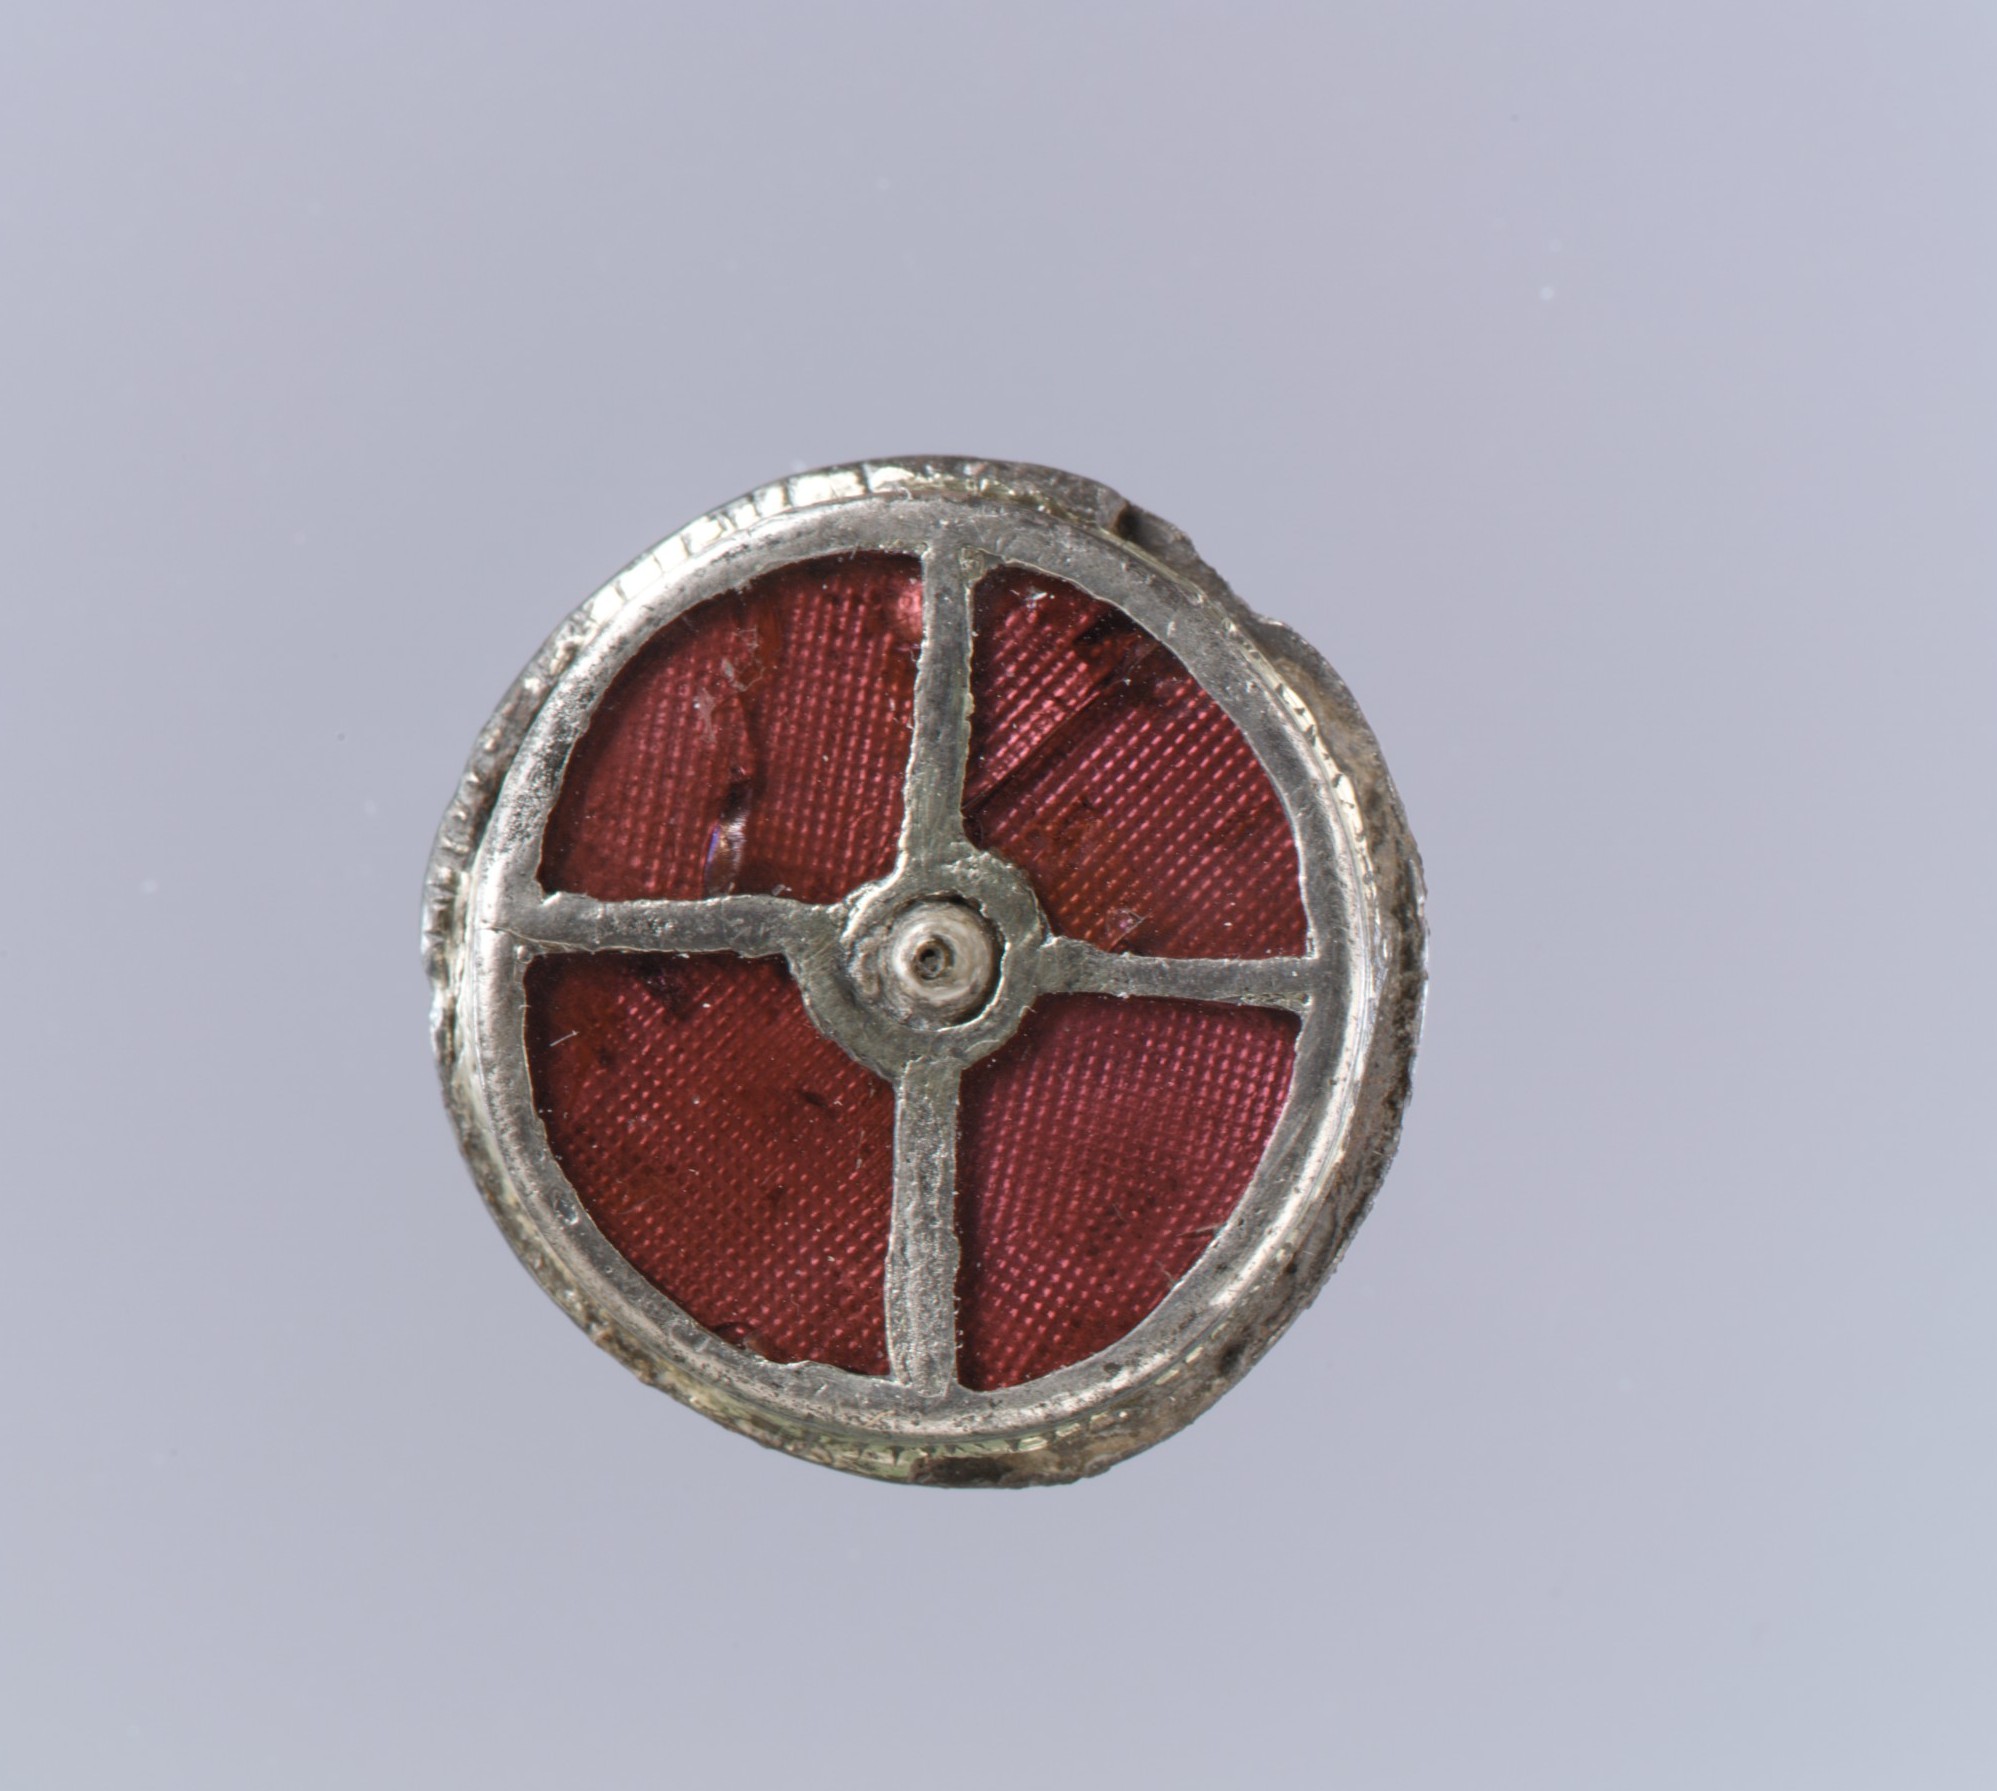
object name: brooch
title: Disk Brooch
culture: frankish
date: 501-550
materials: foil, garnet, pearl, silver gilt